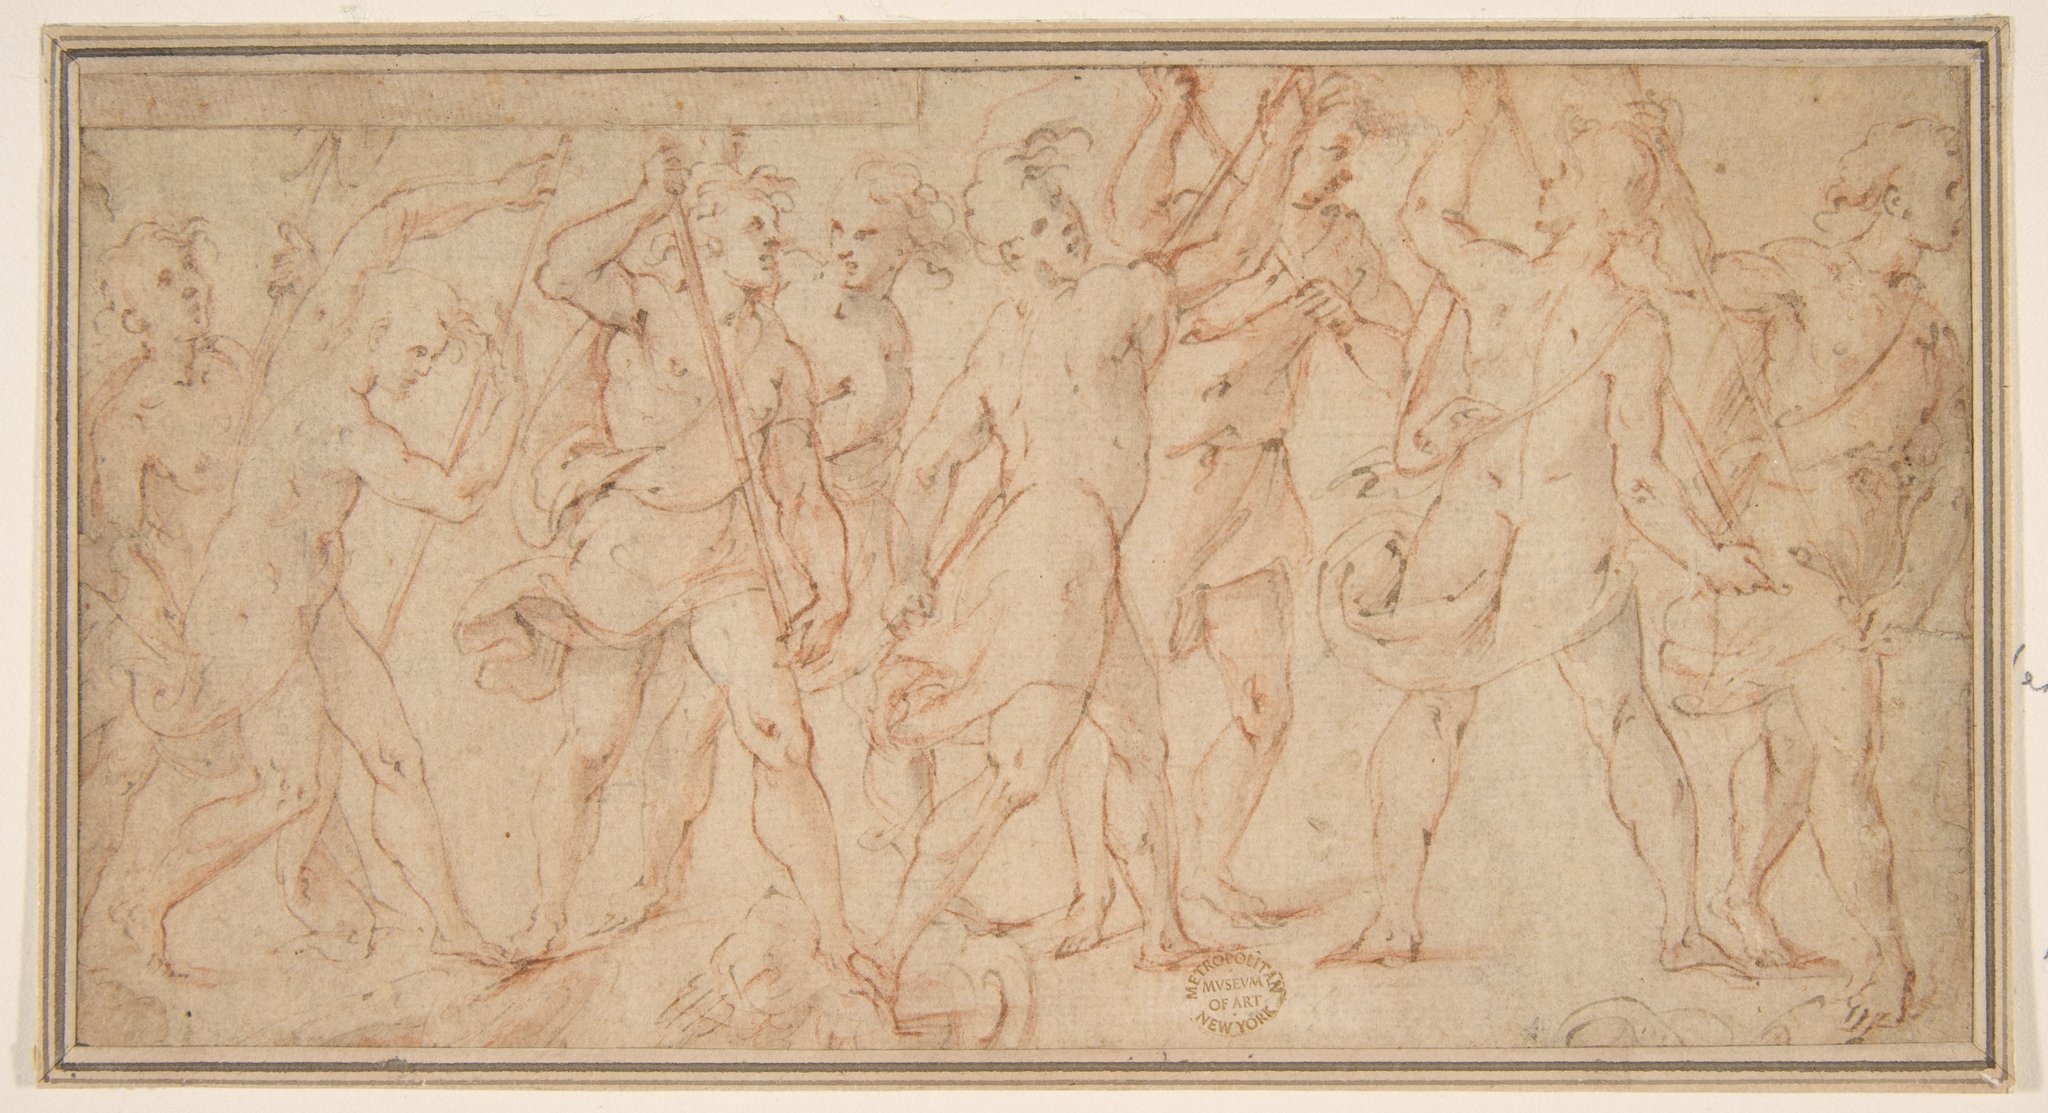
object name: drawing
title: Procession of figures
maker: carlo urbino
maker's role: artist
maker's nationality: italian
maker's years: 1505-1605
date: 1510-1585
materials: chalk, ink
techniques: brush, pen, wash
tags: weapons,men